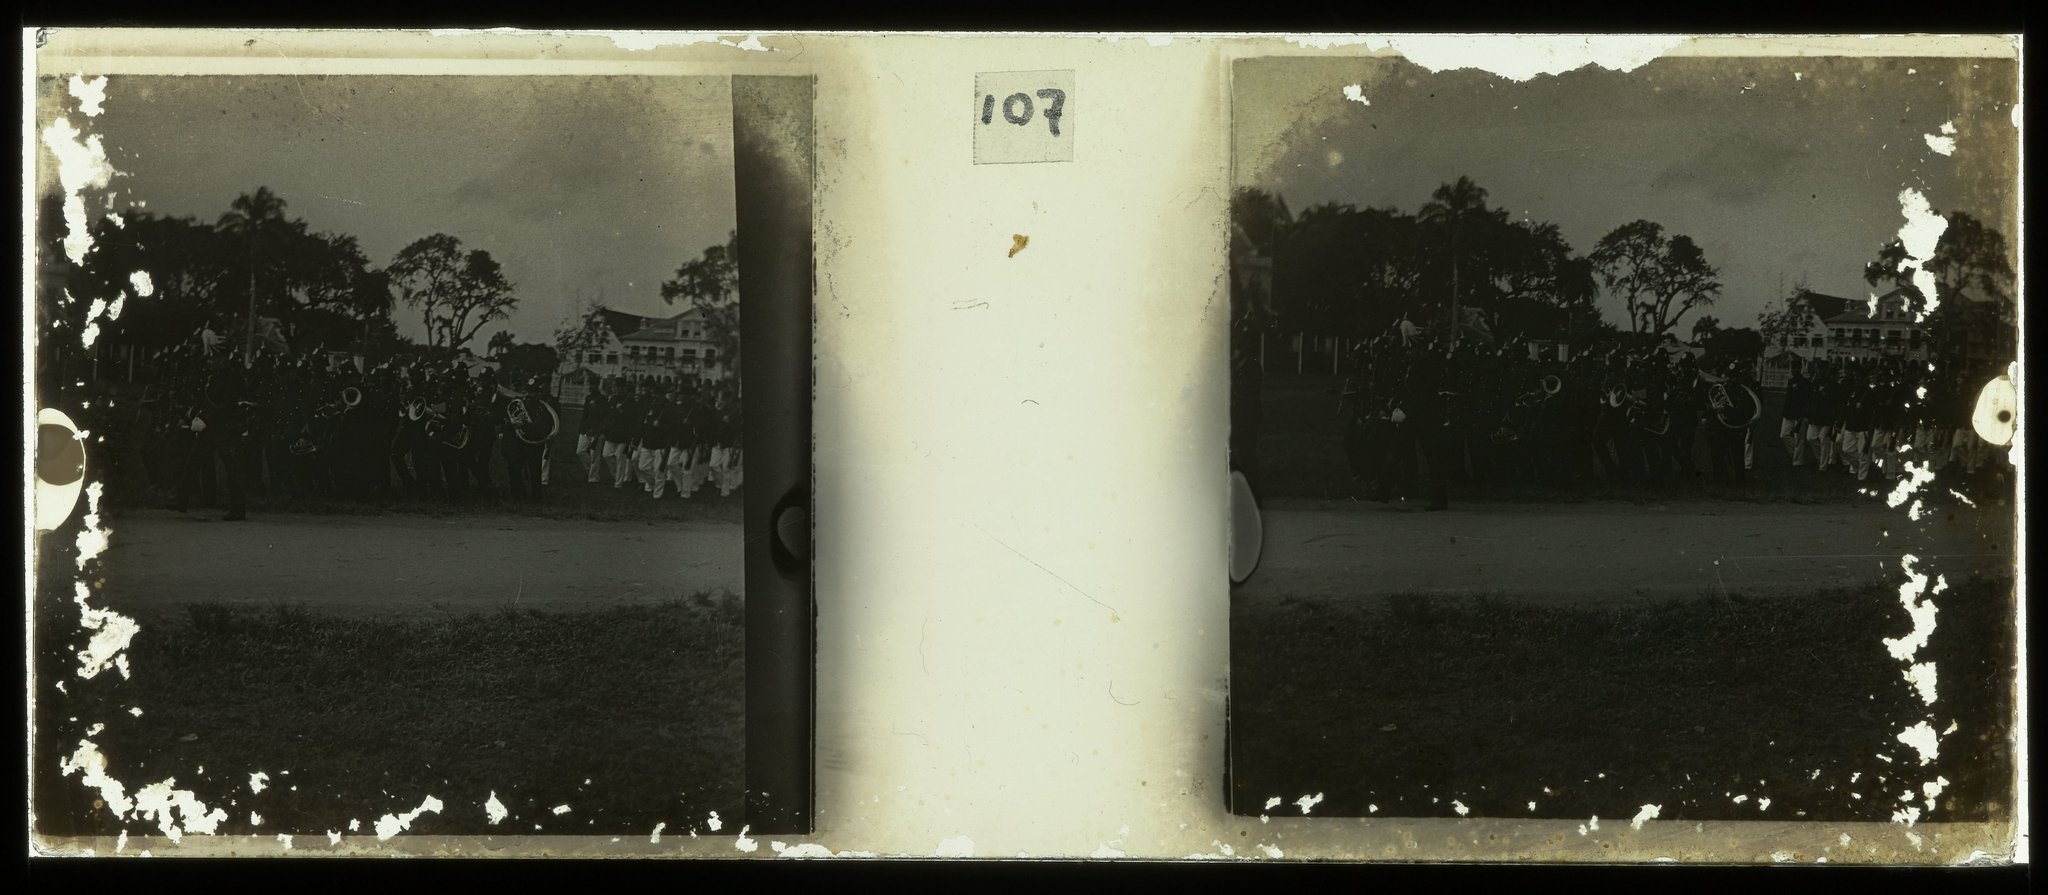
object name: stereograph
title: Plantage Accaribo met woonhuis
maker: theodoor brouwers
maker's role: amateurfotograaf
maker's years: 1874-1932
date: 1913-1930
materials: glass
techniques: photography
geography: suriname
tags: amsterdam, theodoor brouwers, plantation, suriname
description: In de periode 1911-1932 woonde op plantage Accaribo in Suriname de familie Brouwers van wie de foto's afkomstig zijn. Rond 1910 vond Theodoor Brouwers werk op plantage Accaribo. In 1929 werd hij eigenaar van de plantage. Op Accaribo werden in zijn tijd bananen geproduceerd en wat koffie.